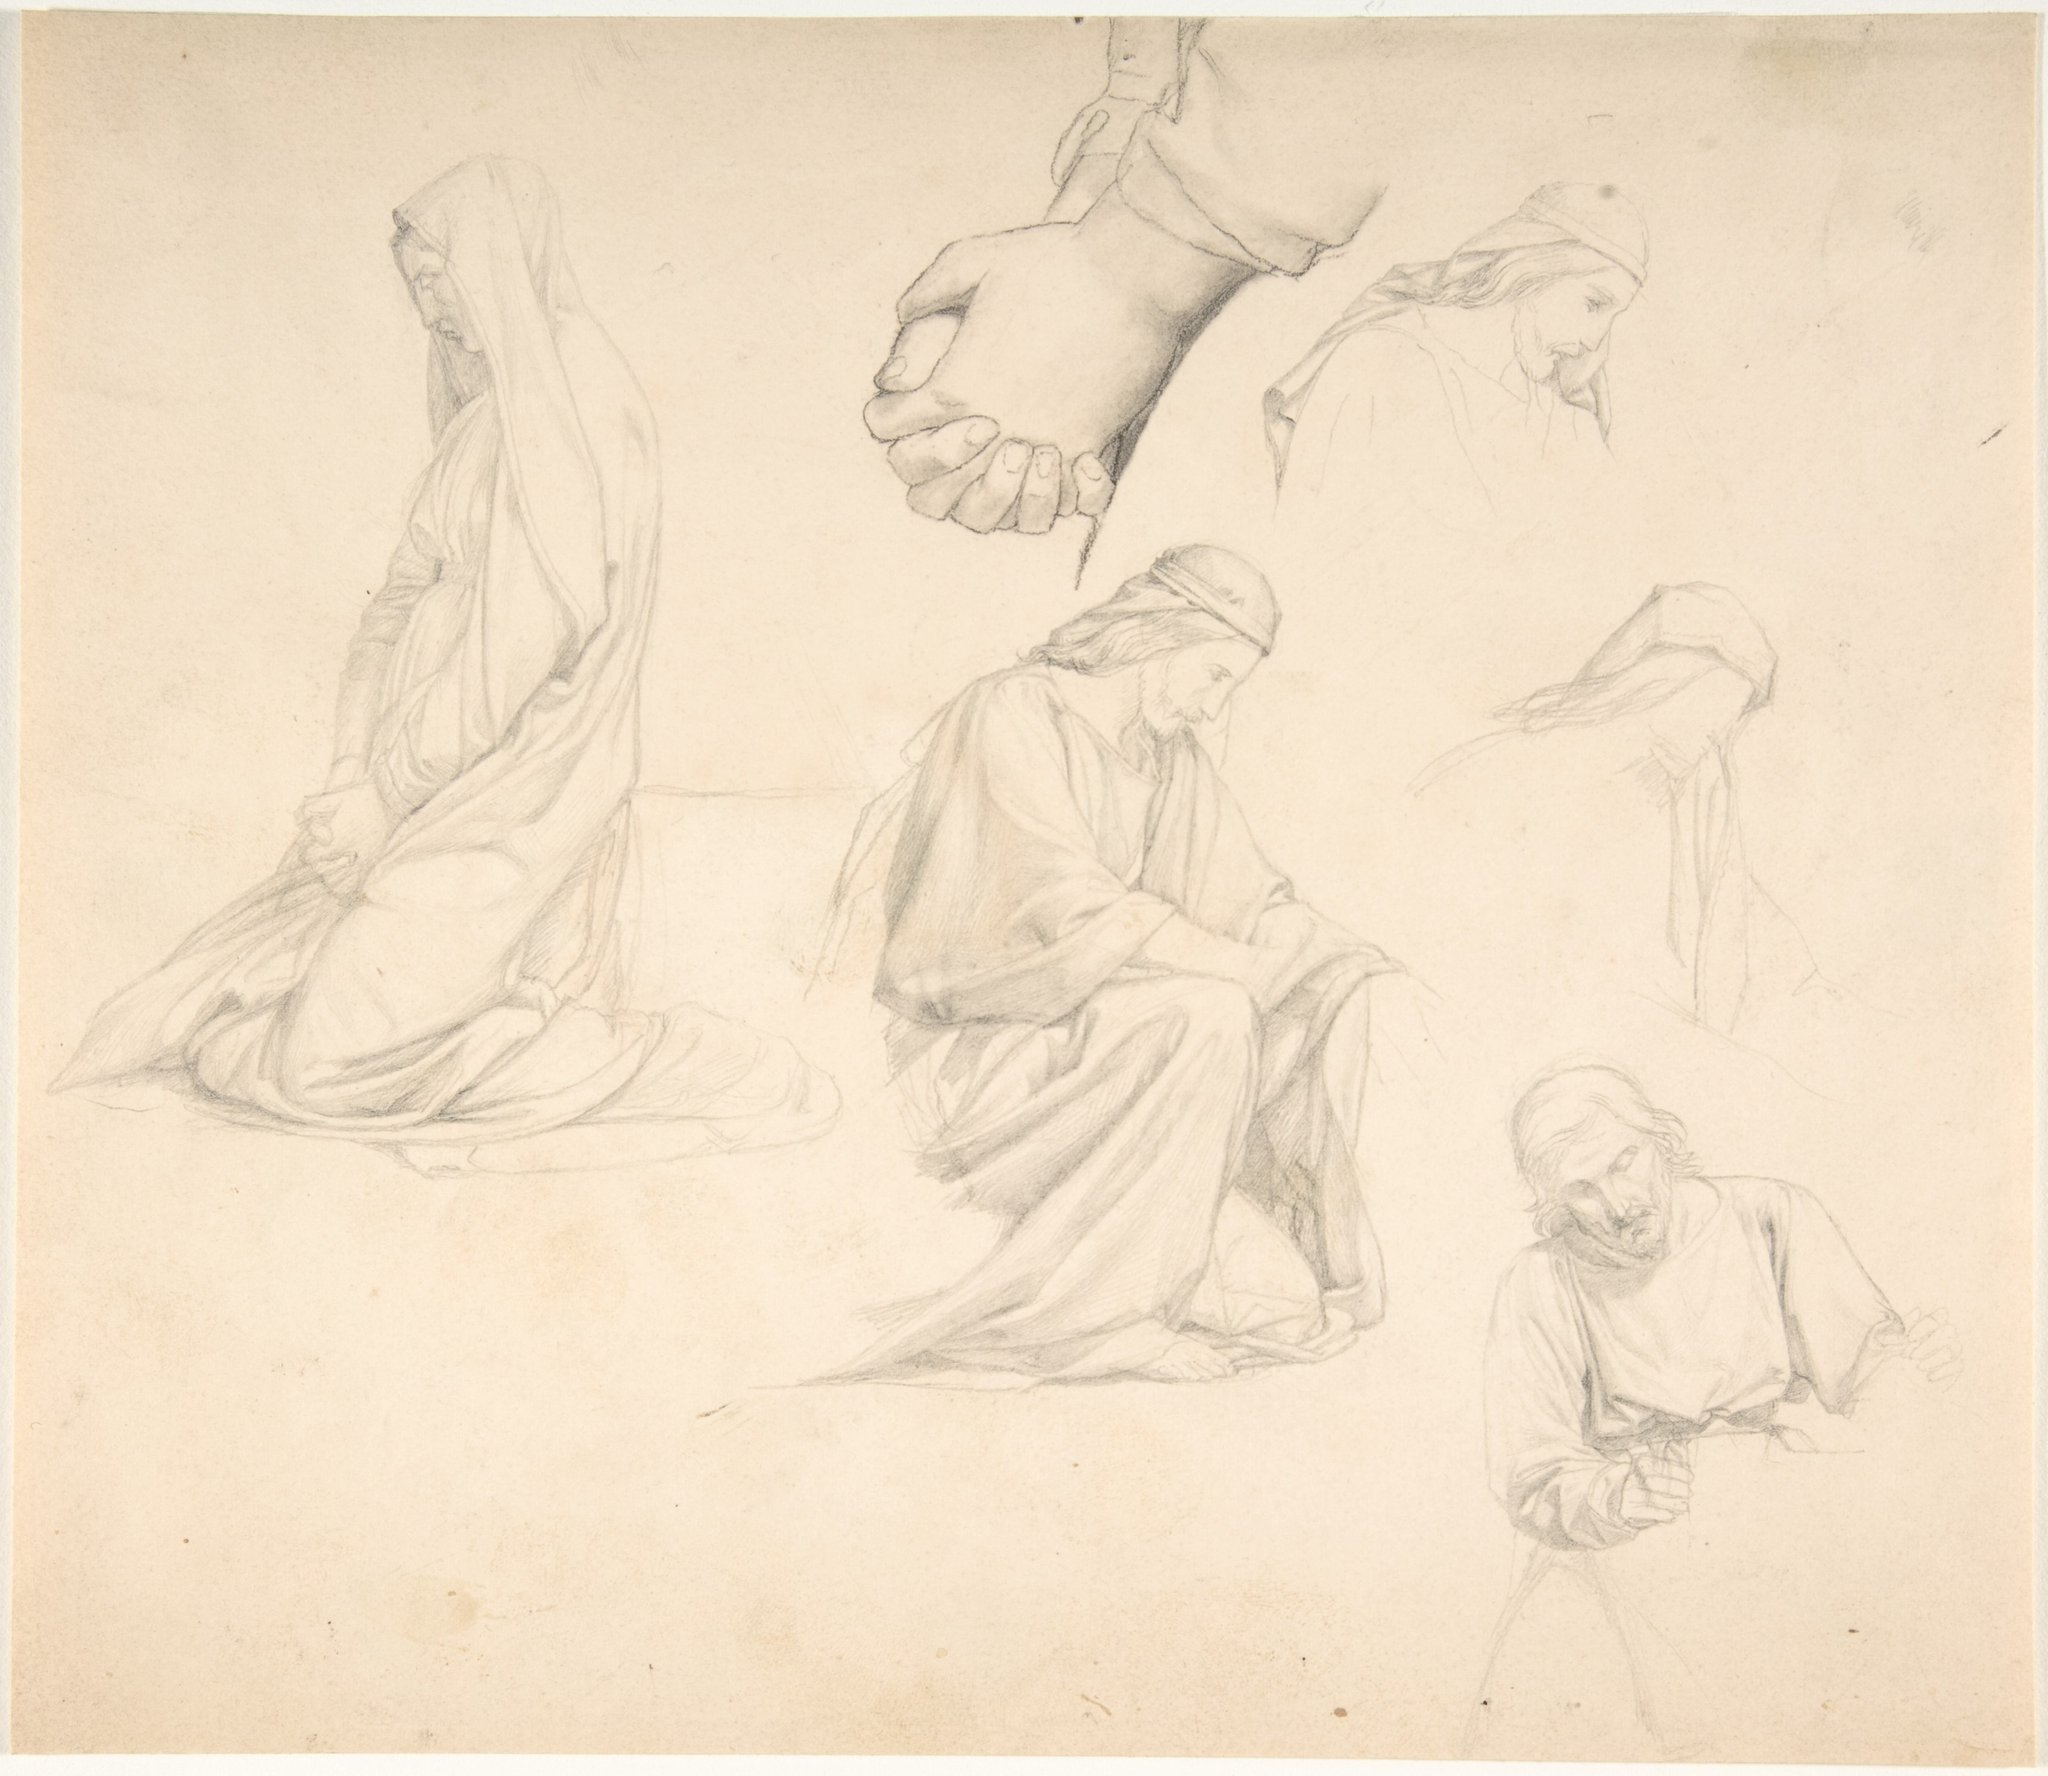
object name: drawing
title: Figure Studies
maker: alphonse-henri périn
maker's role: artist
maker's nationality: french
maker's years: 1798-1874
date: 1810-1874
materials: chalk, graphite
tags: hands,men,women